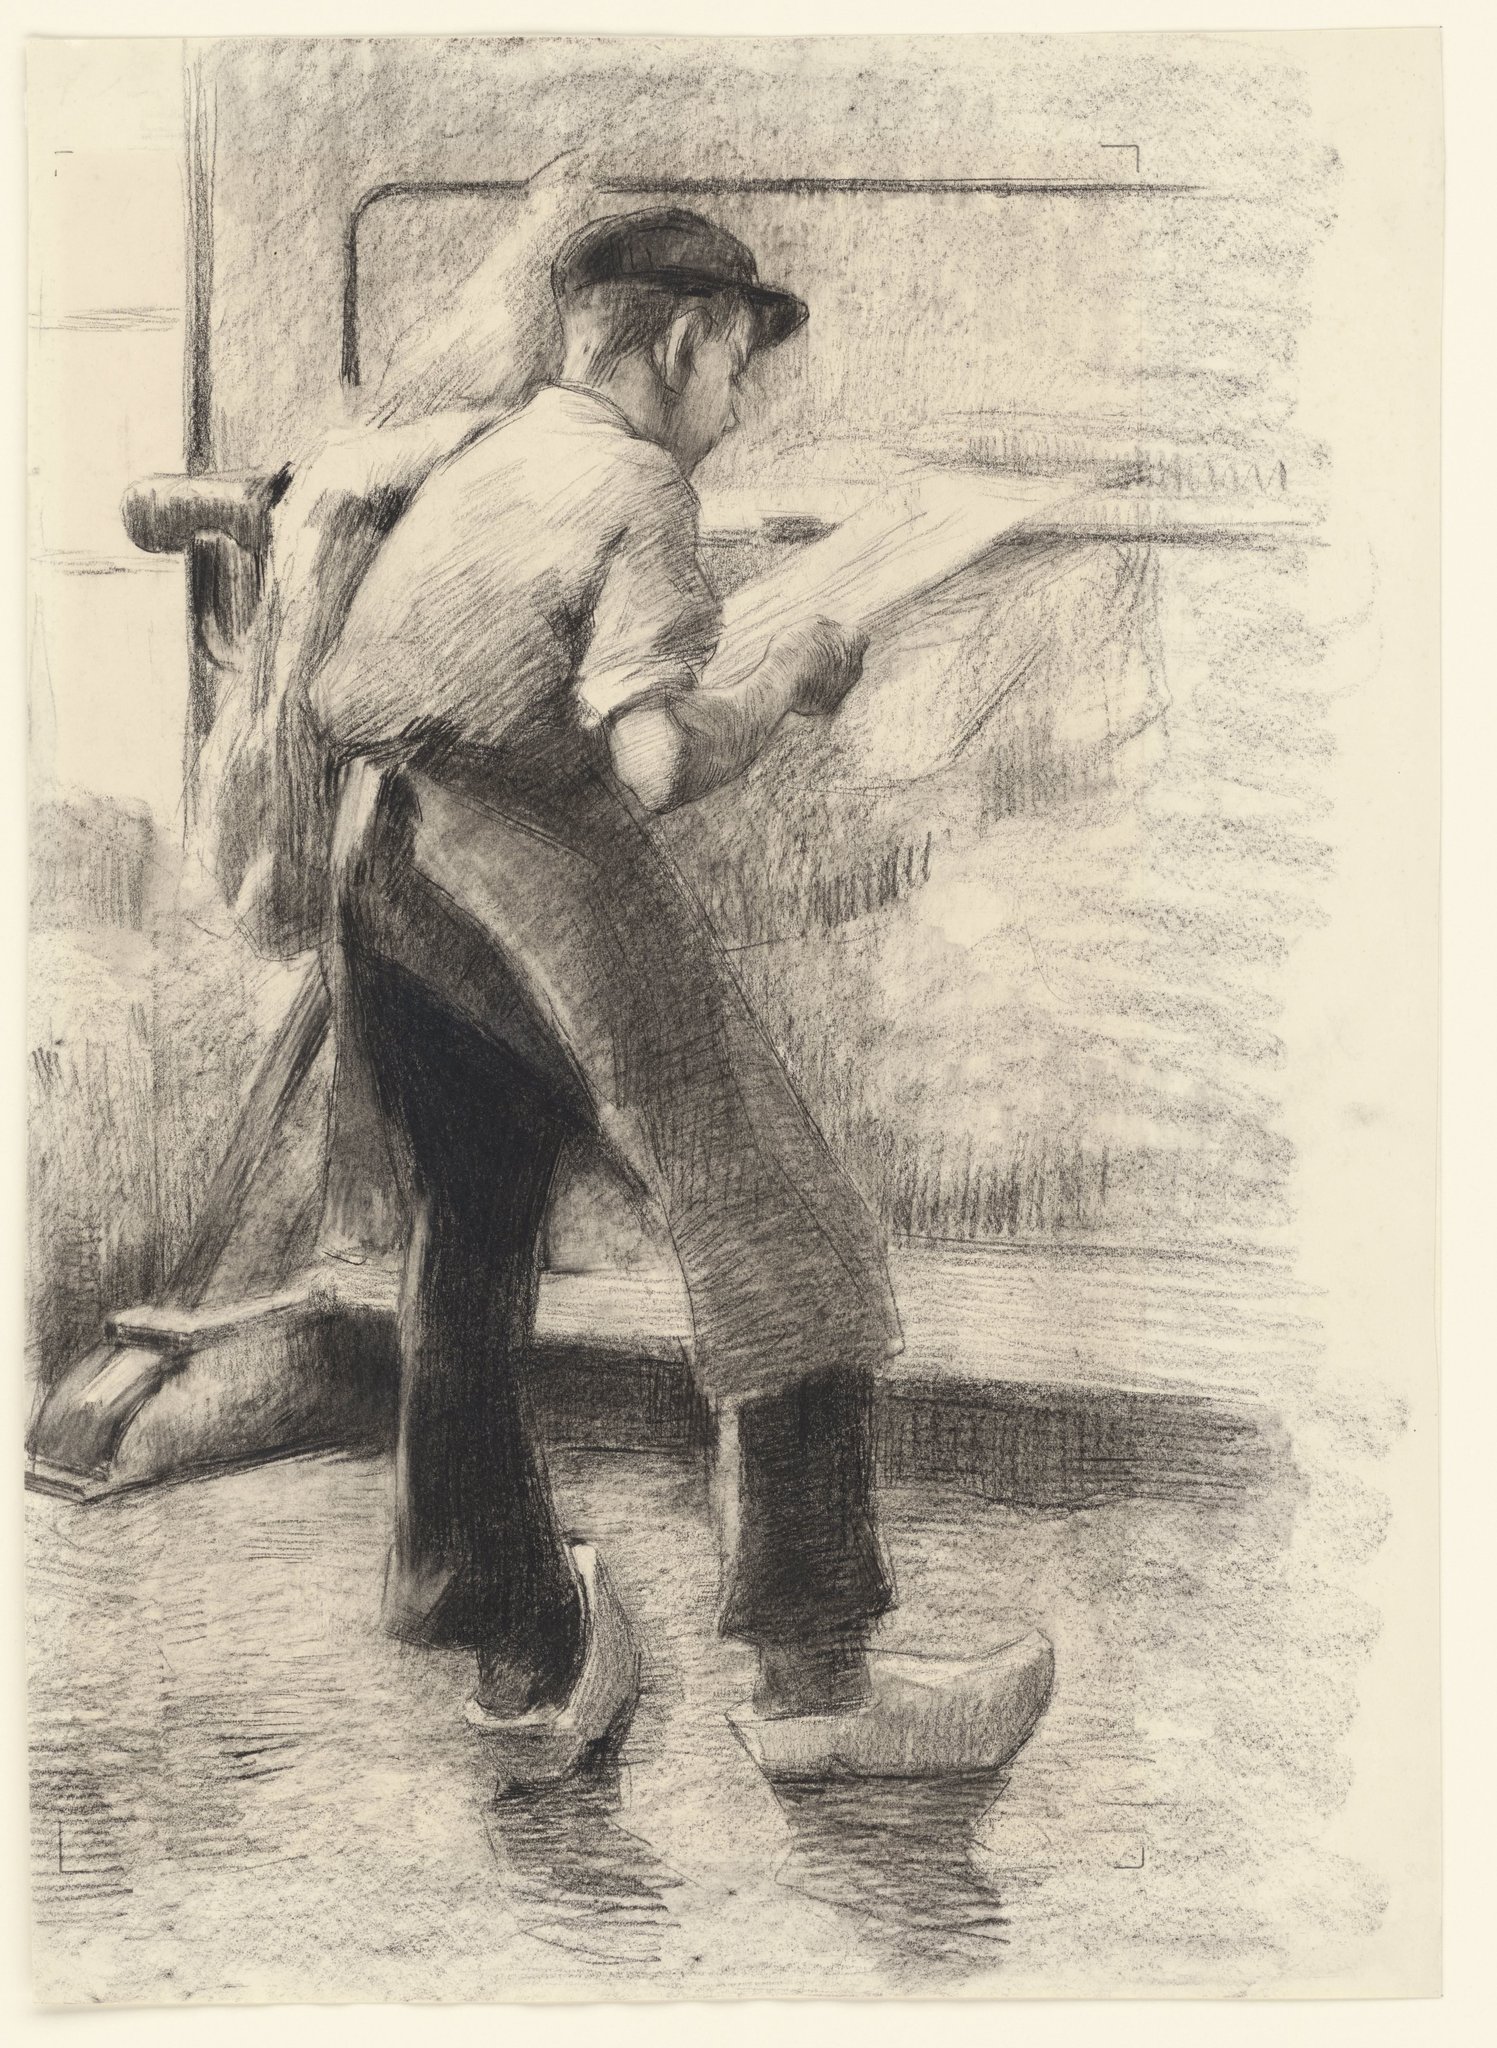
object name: drawing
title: Fabrieksjongen aan het werk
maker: anthon gerhard alexander van rappard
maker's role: draughtsman, print maker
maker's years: 1858-1892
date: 1868-1892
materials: charcoal, paper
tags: cotton (material ~ textile industry)